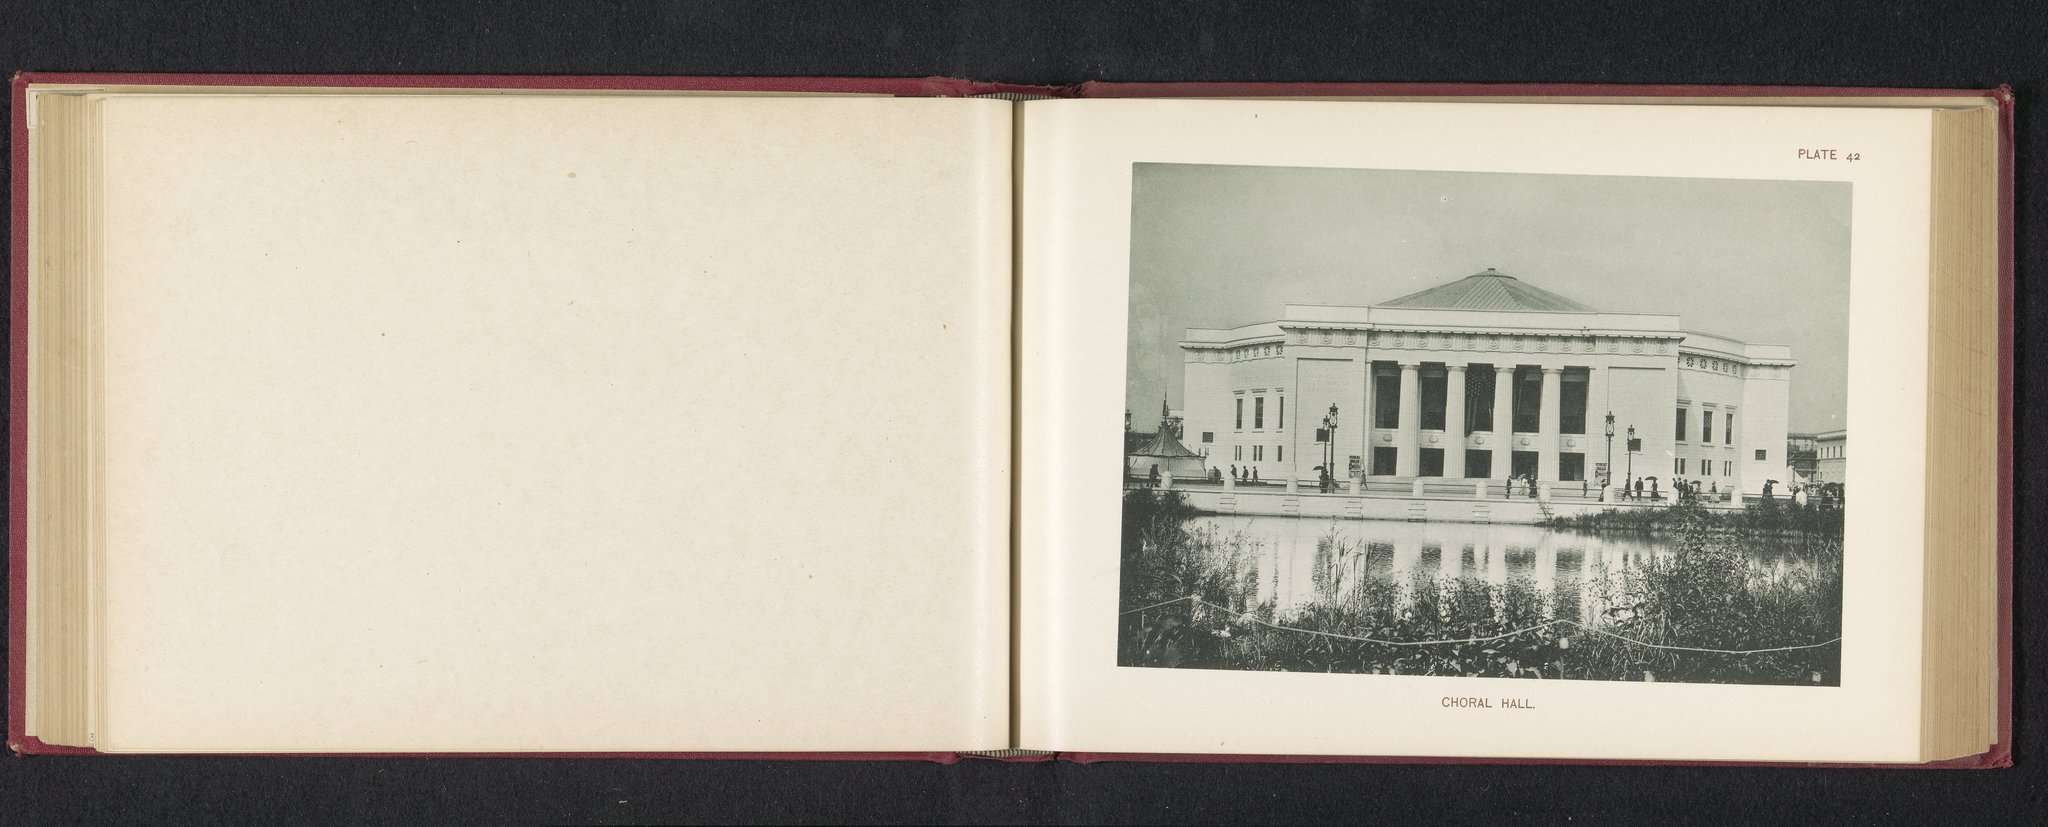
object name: photomechanical print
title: Choral Hall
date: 1893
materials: paper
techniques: photograph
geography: chicago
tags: world fair, world exhibition, concert hall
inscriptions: number: ‘Plate 42’